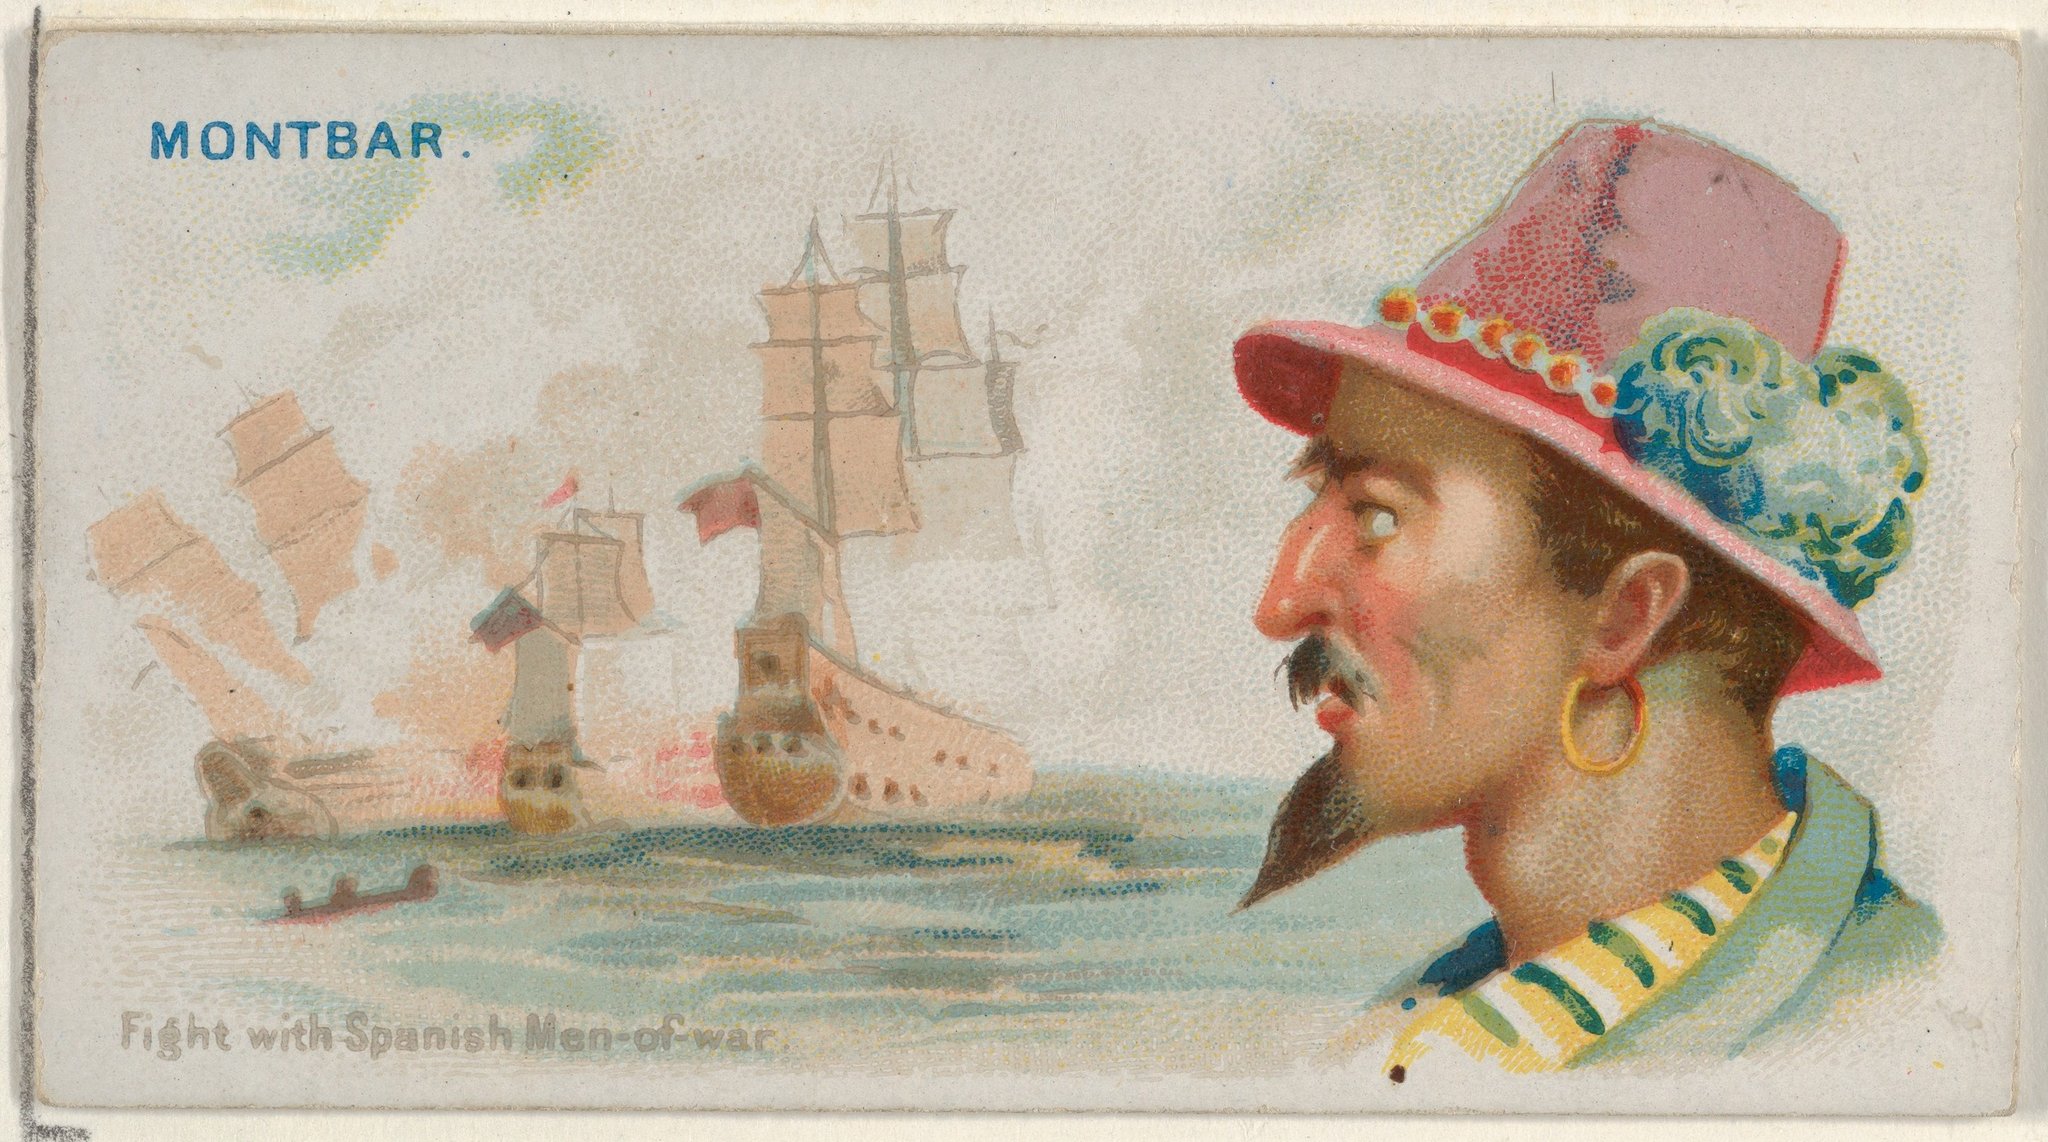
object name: print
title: Montbars, Fight with Spanish Men-of-War, from the Pirates of the Spanish Main series (N19) for Allen & Ginter Cigarettes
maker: allen & ginter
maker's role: publisher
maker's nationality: american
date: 1888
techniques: color lithograph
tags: men,profiles,ships